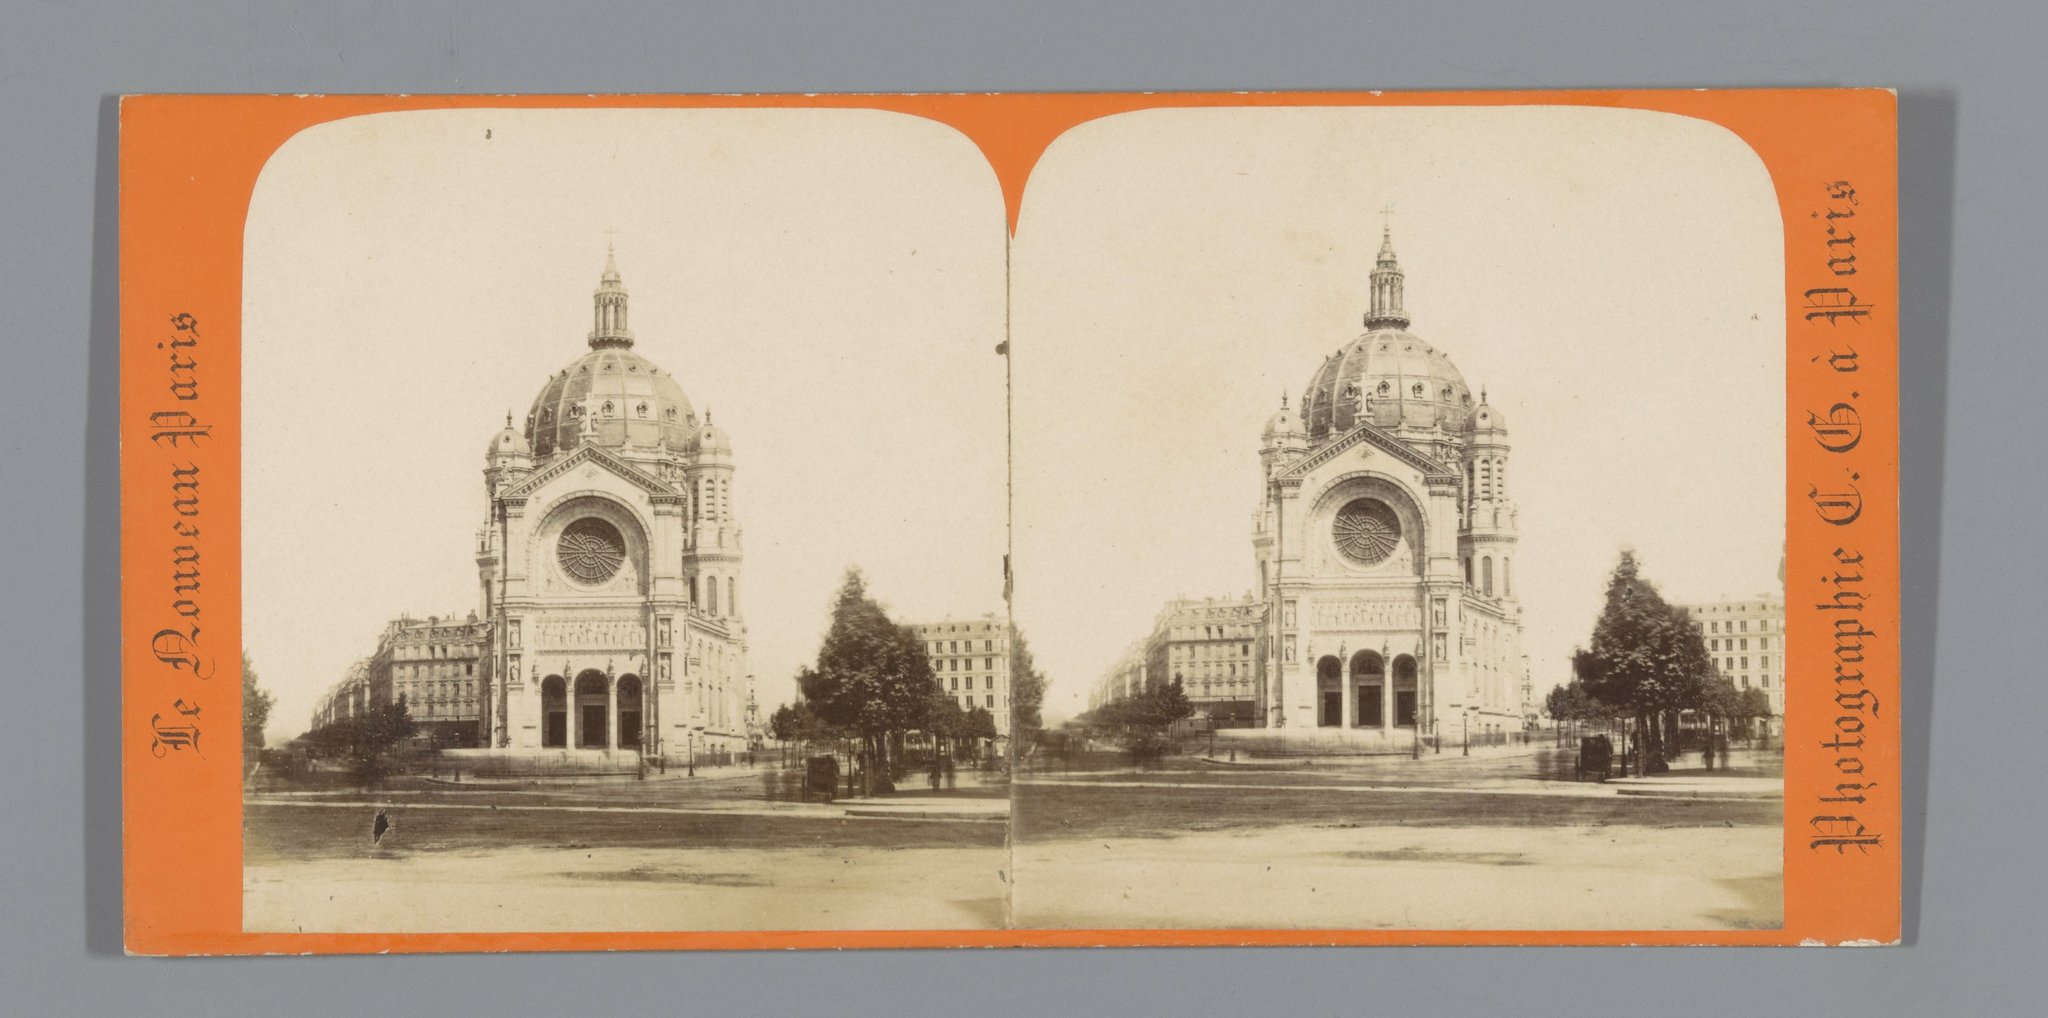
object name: stereograph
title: Le Nouveau Paris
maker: charles gérard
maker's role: fotograaf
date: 1860-1870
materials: cardboard, photographic support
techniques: albumen print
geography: paris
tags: church (exterior), façade (of house or building)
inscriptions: inscription: ‘Photographie C. G. à Paris.’, inscription: ‘St Augustin’